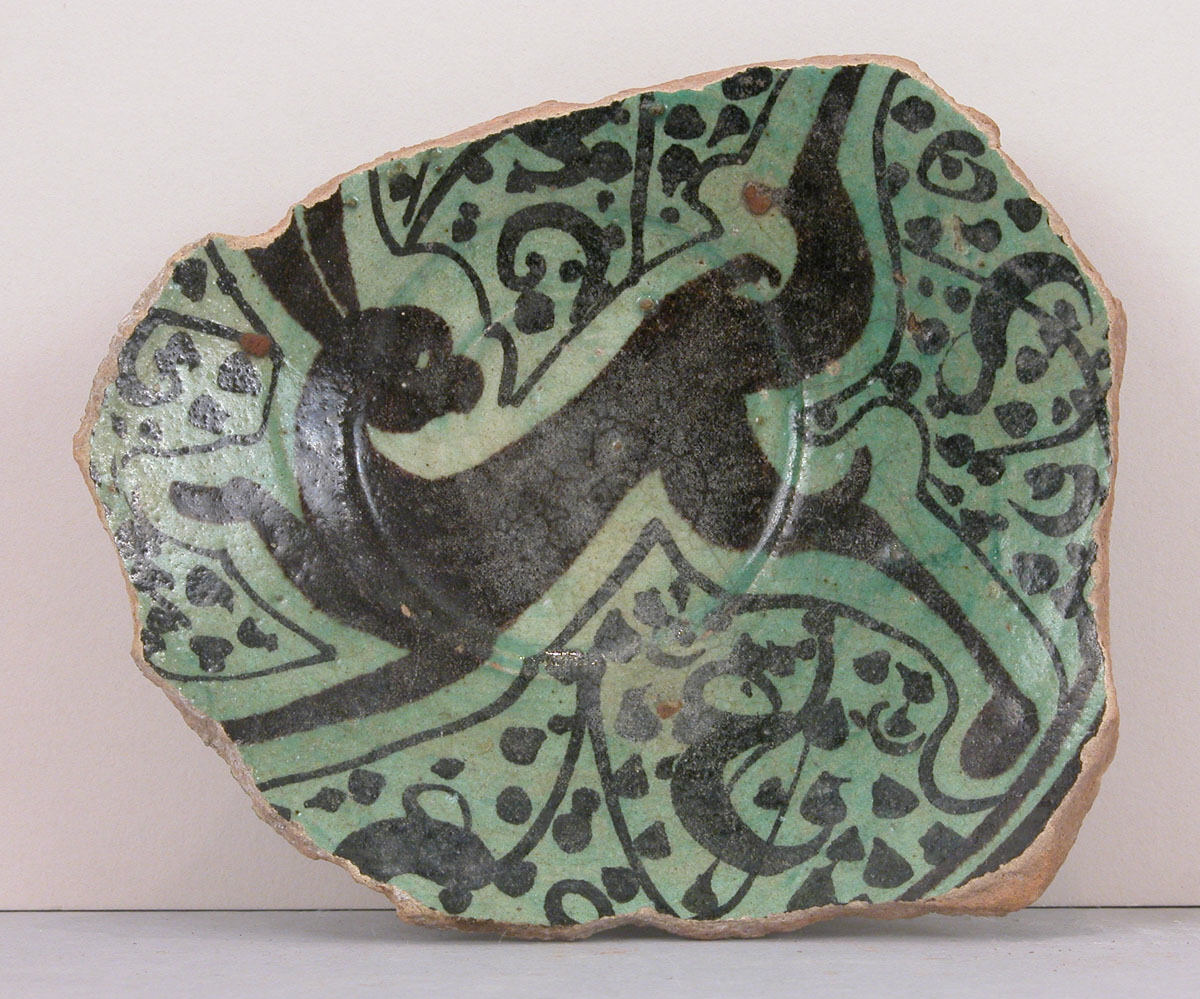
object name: fragment of a bowl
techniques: painting, underglaze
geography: syria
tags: animals